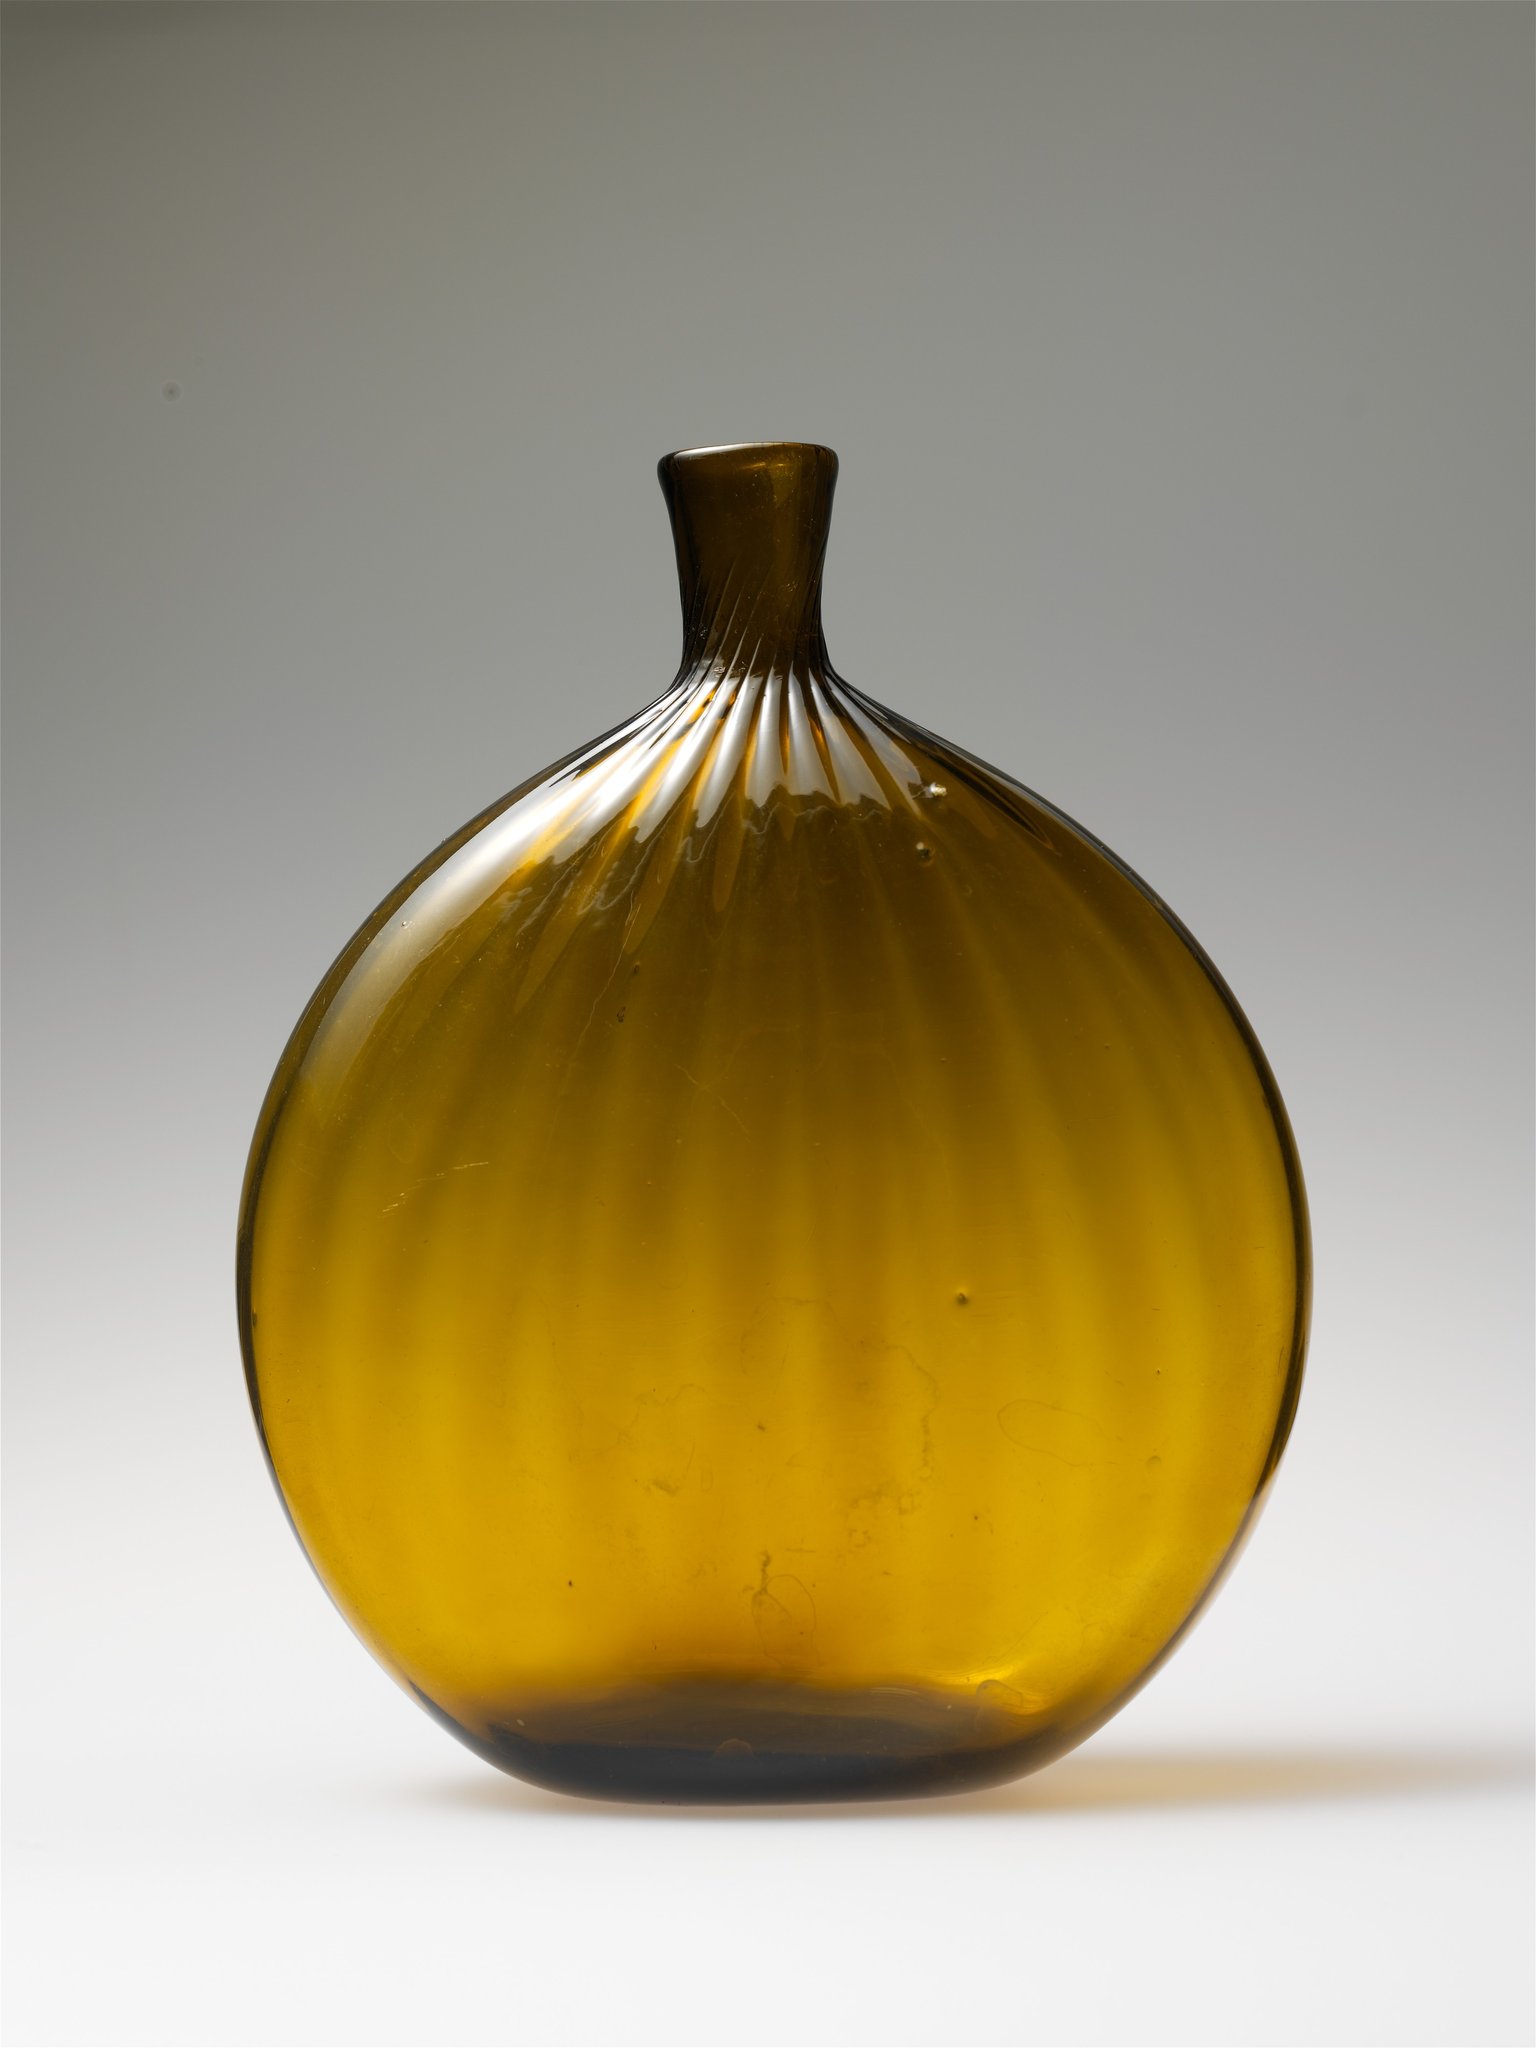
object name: pocket bottle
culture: american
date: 1815-1845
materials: glass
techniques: glassblowing, molding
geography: united states